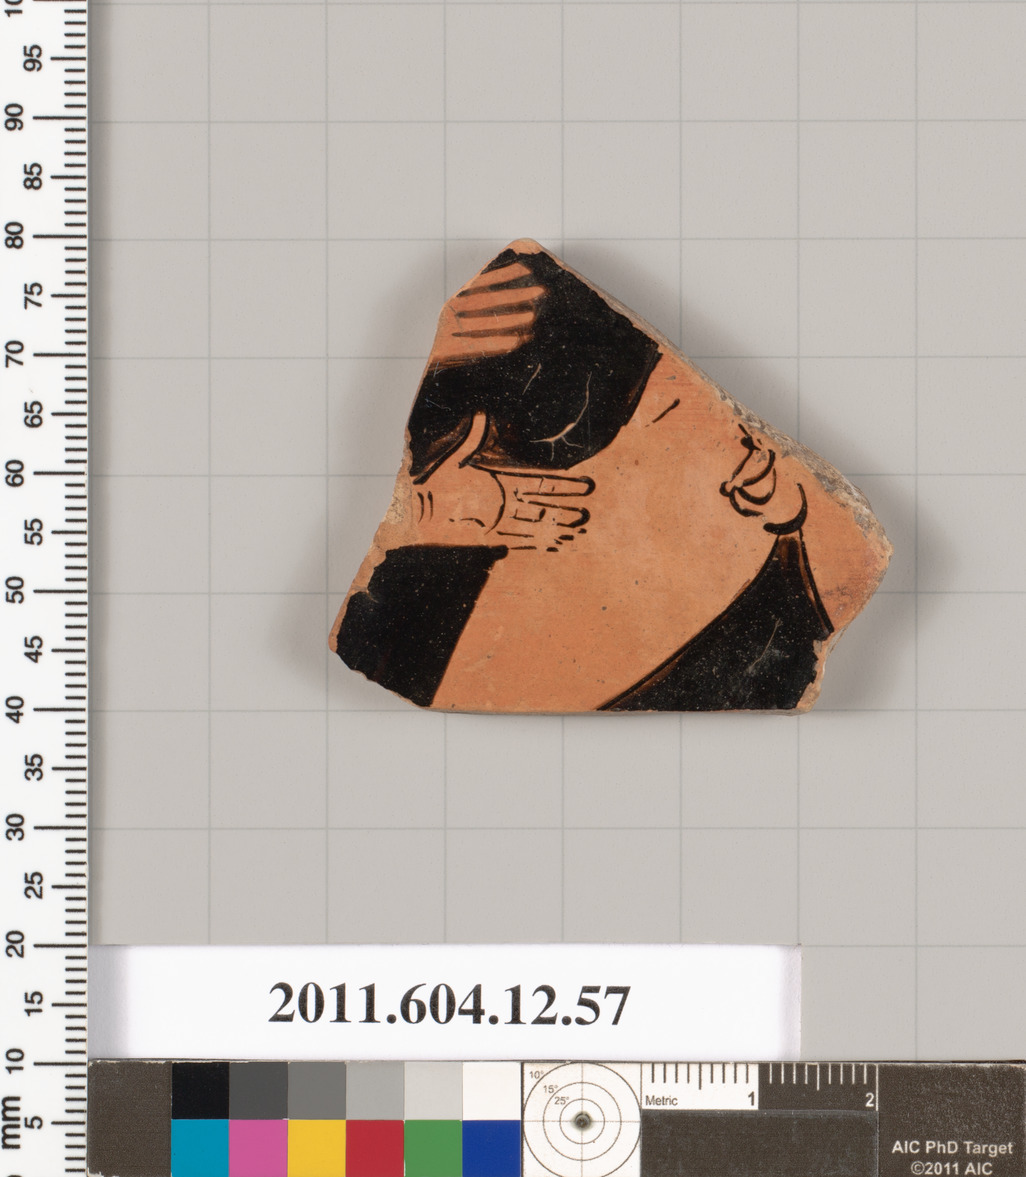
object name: krater fragment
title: Terracotta fragment of a krater (deep bowl)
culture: greek or south italian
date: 400-301 BCE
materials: terracotta